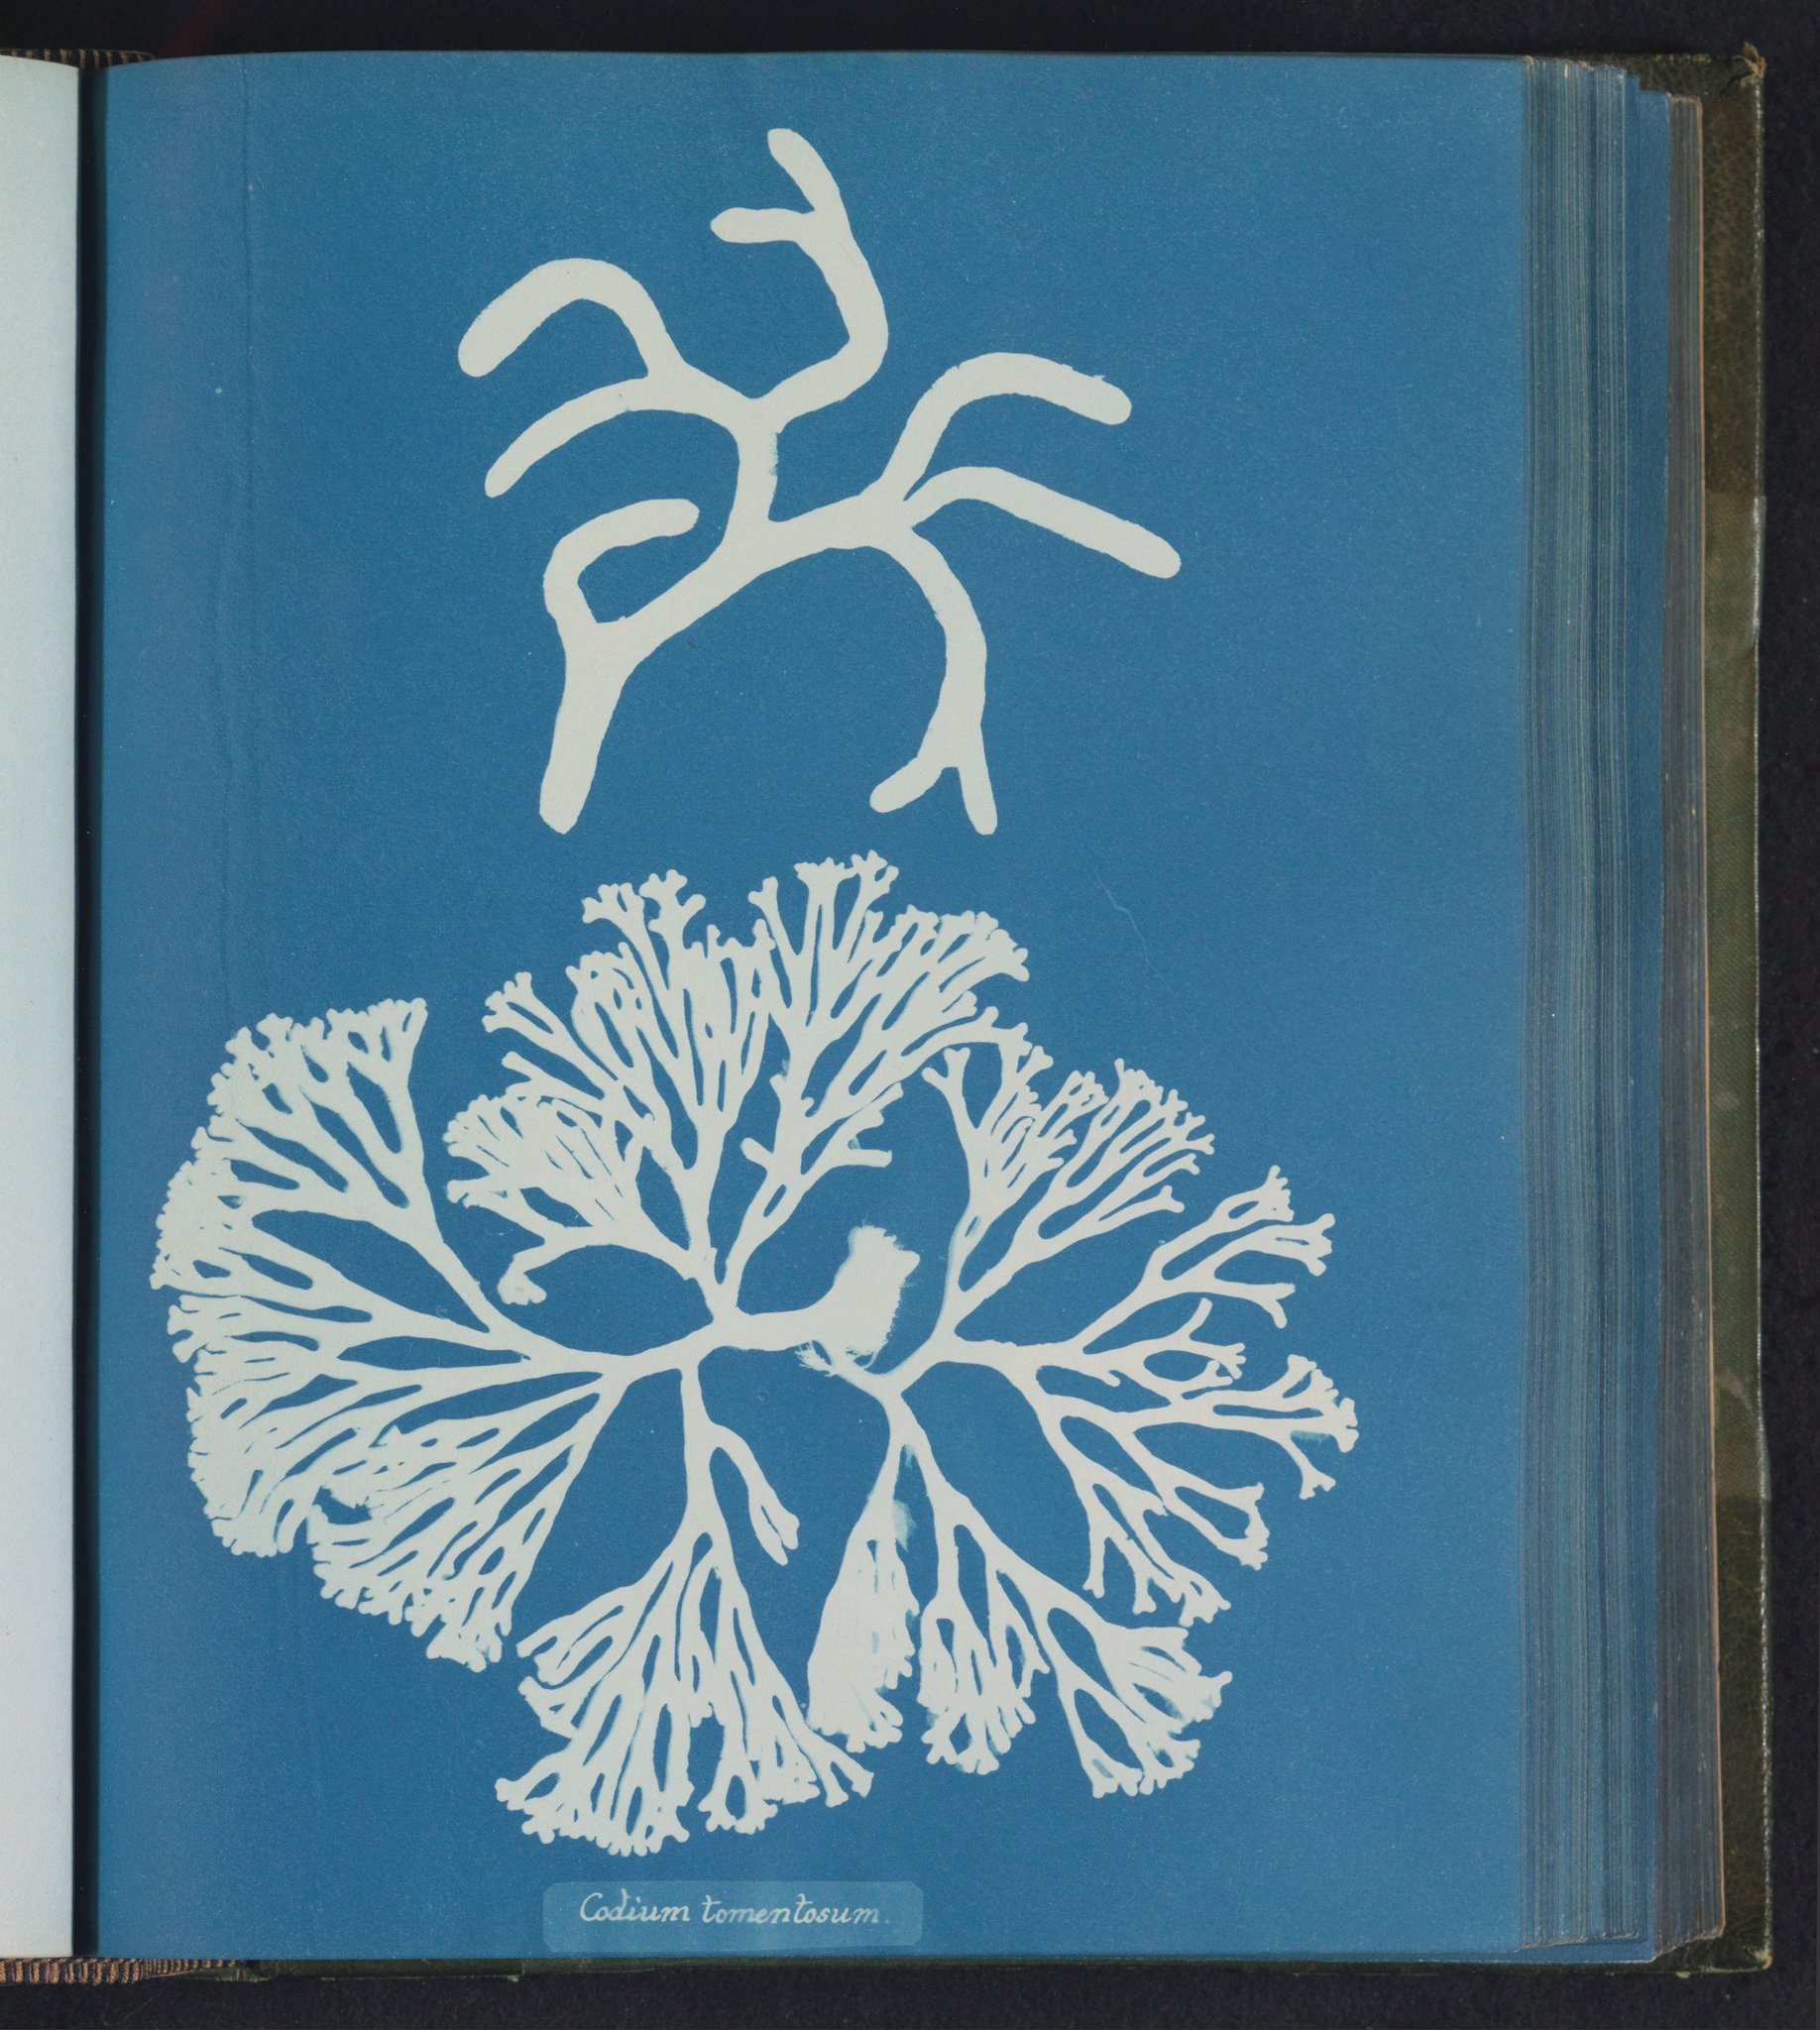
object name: page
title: Zeewier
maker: anna atkins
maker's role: fotograaf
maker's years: 1799-1871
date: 1843-1853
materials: photographic support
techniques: cyanotype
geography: united kingdom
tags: algae, seaweed